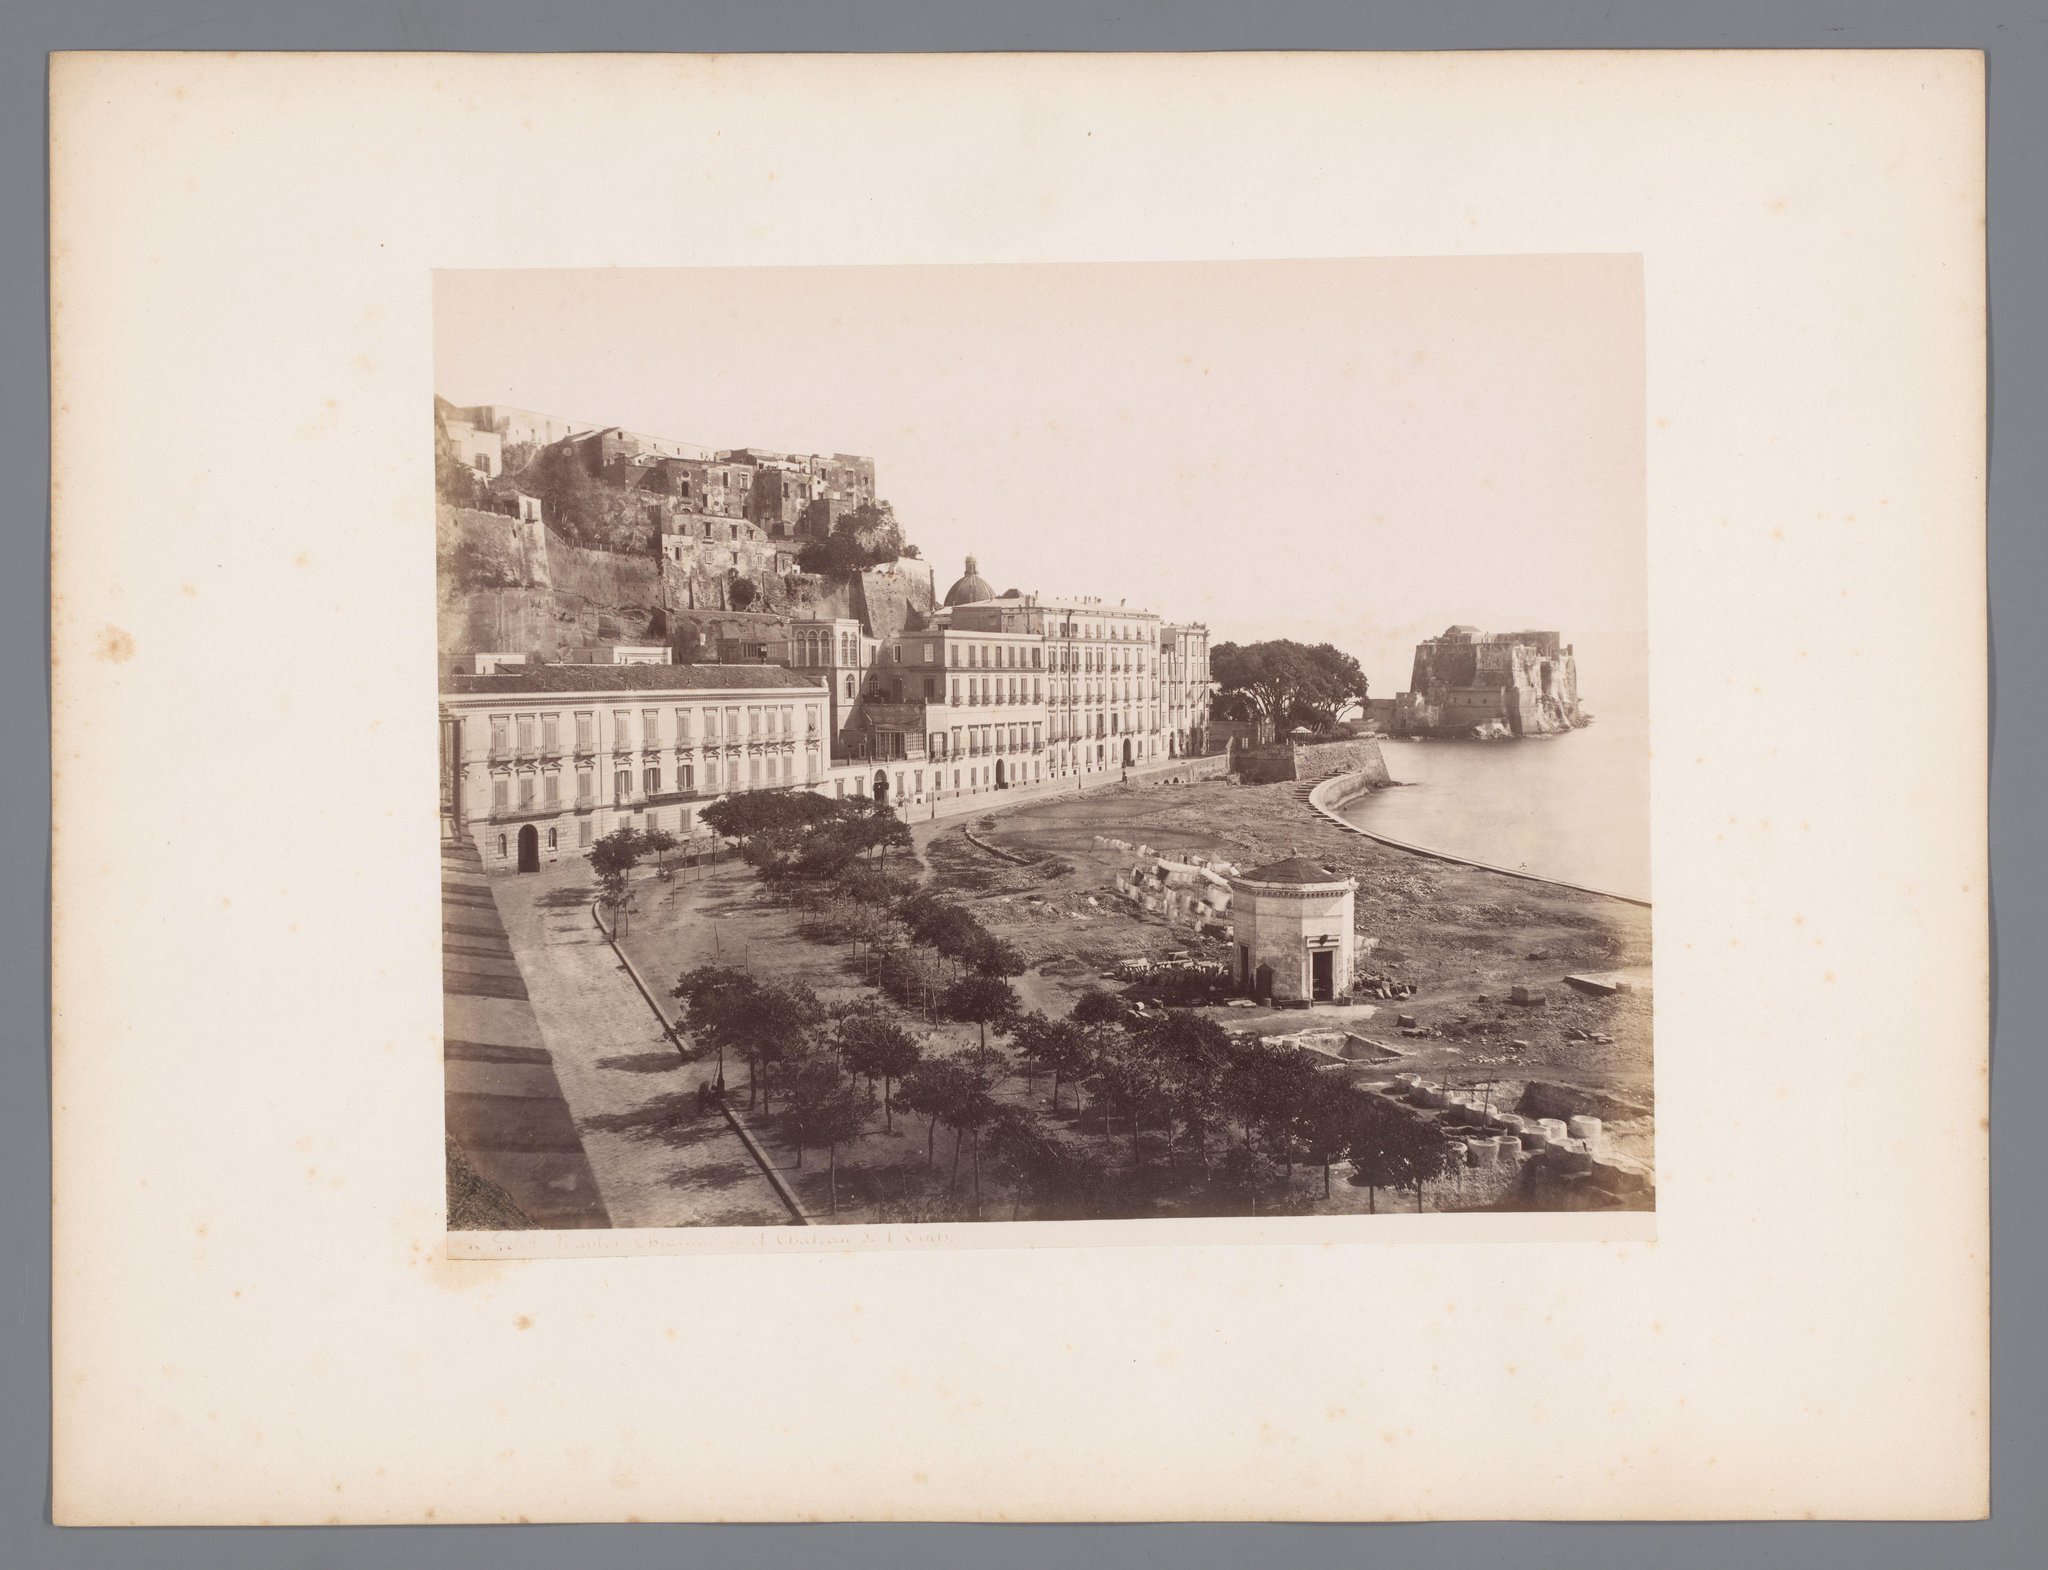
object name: photograph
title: Chateau [...] et Chateau de l'oeufs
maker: giorgio sommer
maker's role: fotograaf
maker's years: 1834-1914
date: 1857-1914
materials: cardboard, paper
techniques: albumen print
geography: naples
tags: urban housing, landscape with tower or castle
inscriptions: number: ‘16 -’, number: ‘[...]’, number: ‘12’